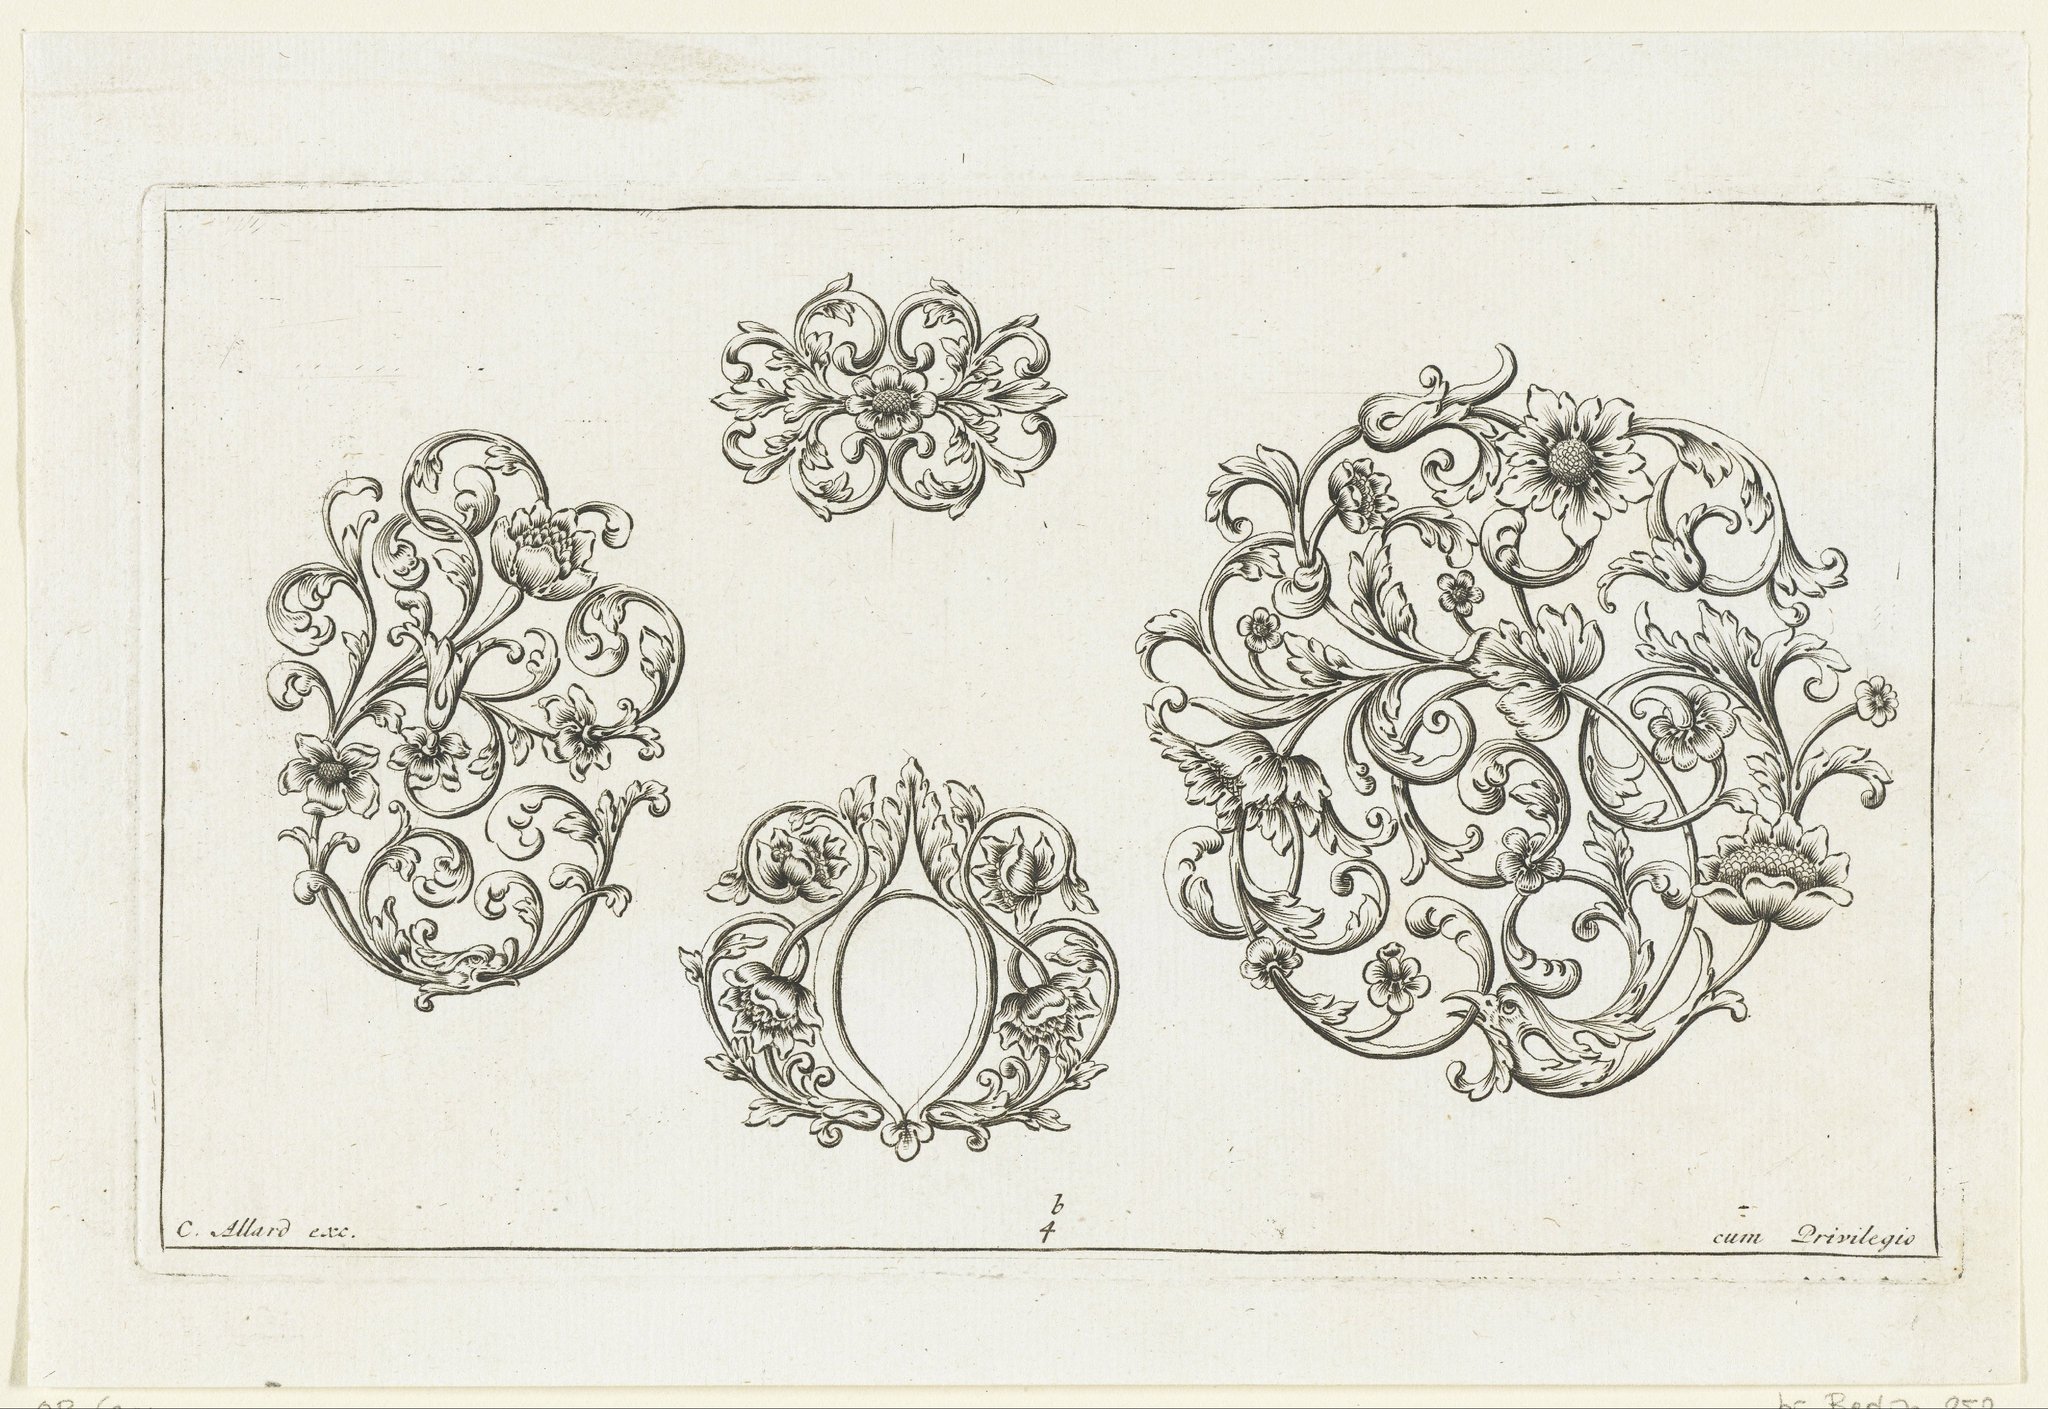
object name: print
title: Doorgebroke Zilver-Smids werk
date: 1690-1700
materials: paper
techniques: engraving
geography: amsterdam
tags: ornament derived from plant forms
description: Blad uit tweede serie van 6 bladen met voorbeelden van ornamenten voor zilversmeden.